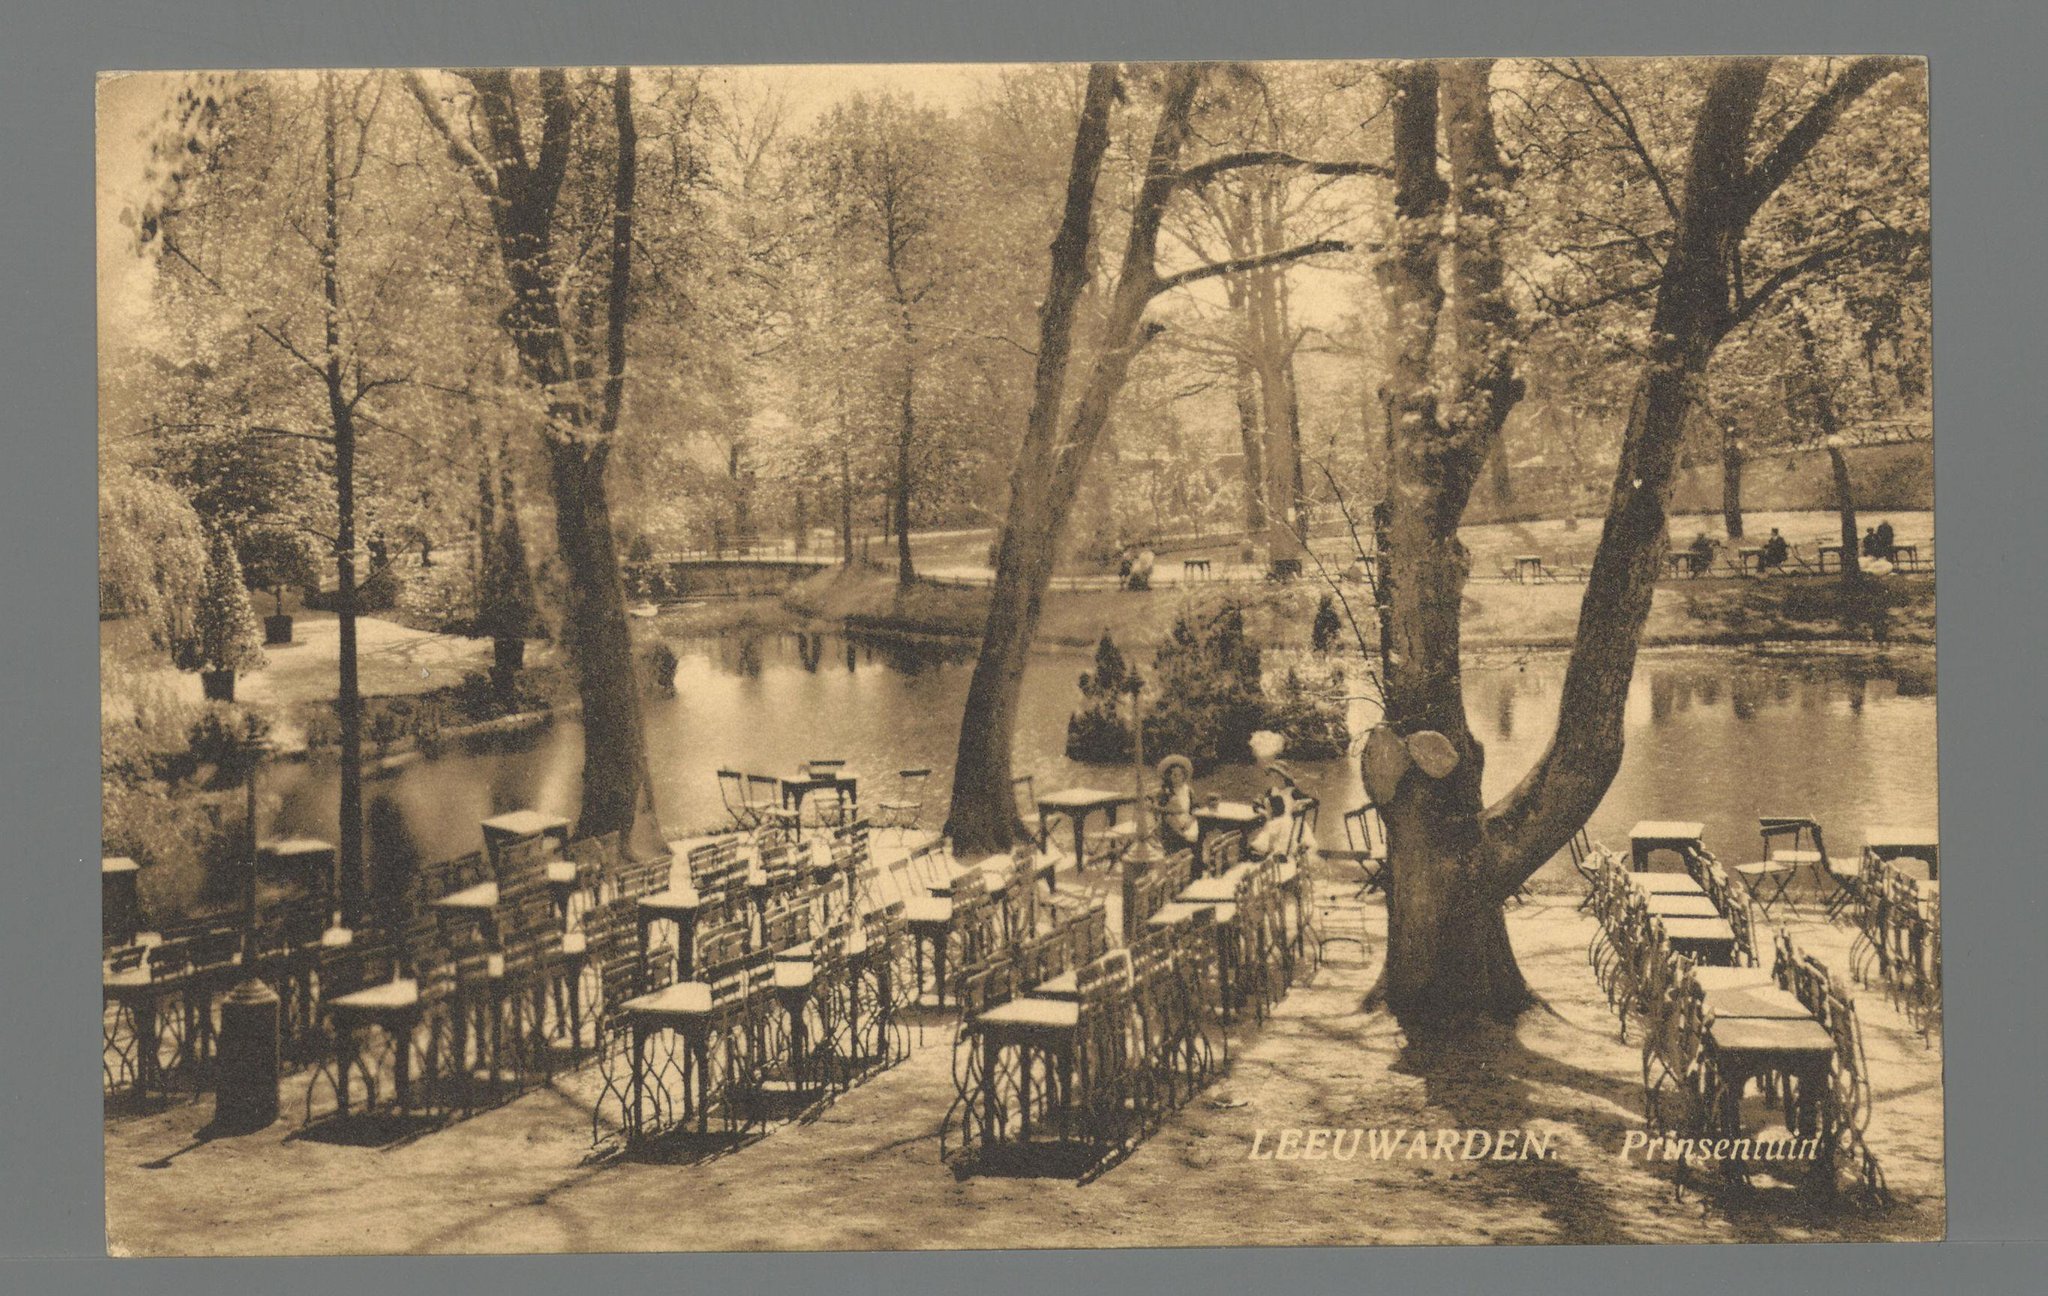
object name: ansichtkaart, prentbriefkaart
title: Leeuwarden. Prinsentuin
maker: Anonymous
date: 1905-1930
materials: cardboard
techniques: photograph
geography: leeuwarden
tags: pond, public gardens, park